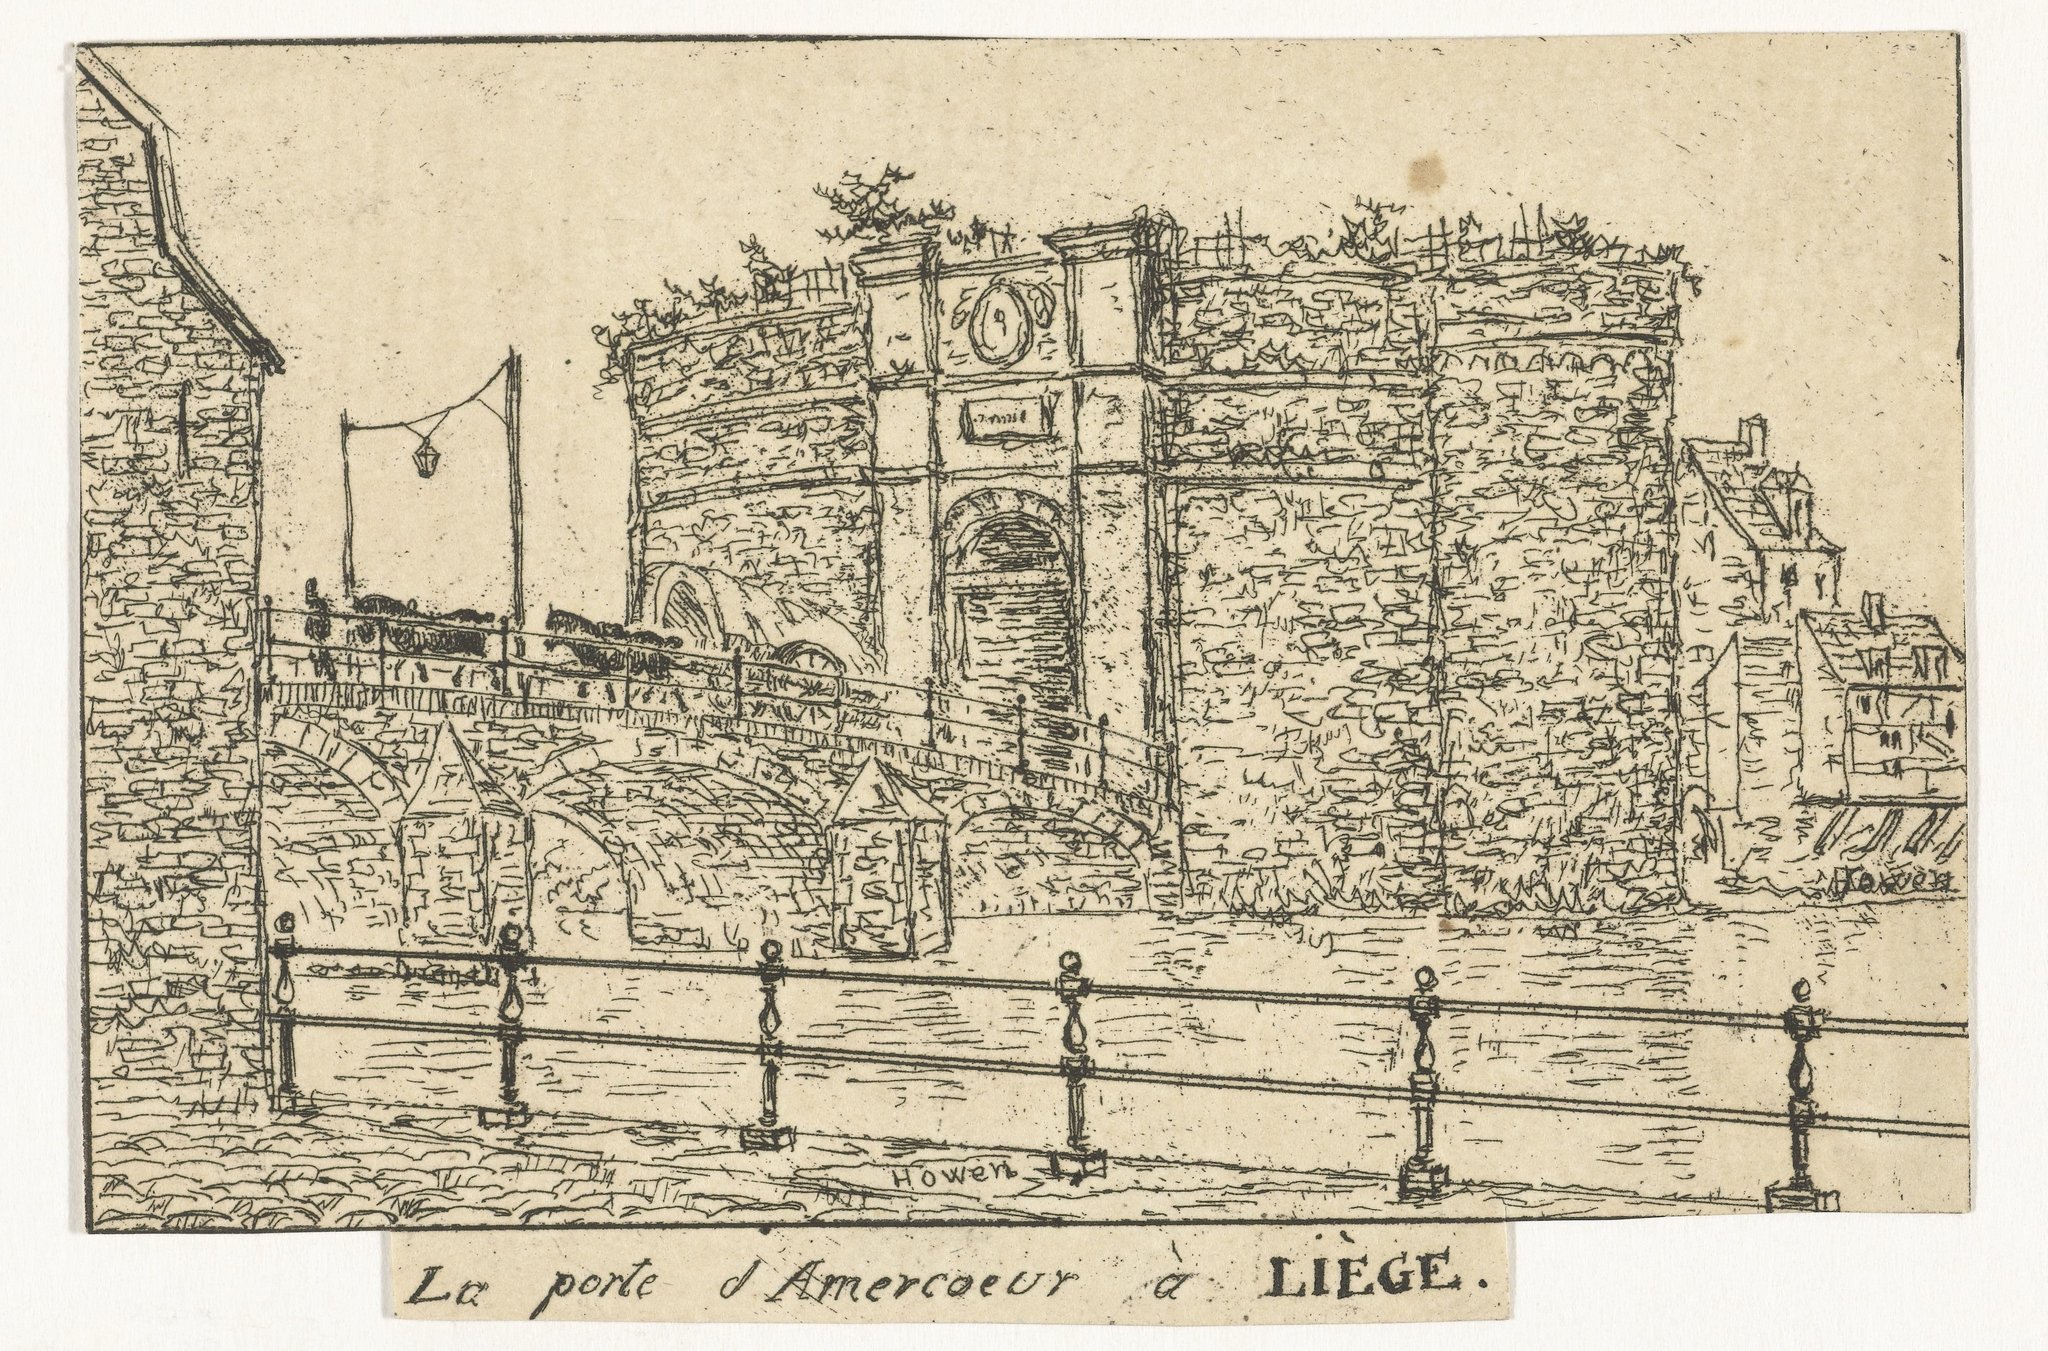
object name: print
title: Amercoeurpoort te Luik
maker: otto baron howen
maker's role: draughtsman, print maker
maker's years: 1774-1848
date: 1784-1848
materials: paper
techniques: etching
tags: city-gate, liège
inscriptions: collector's mark: Lugt 2228